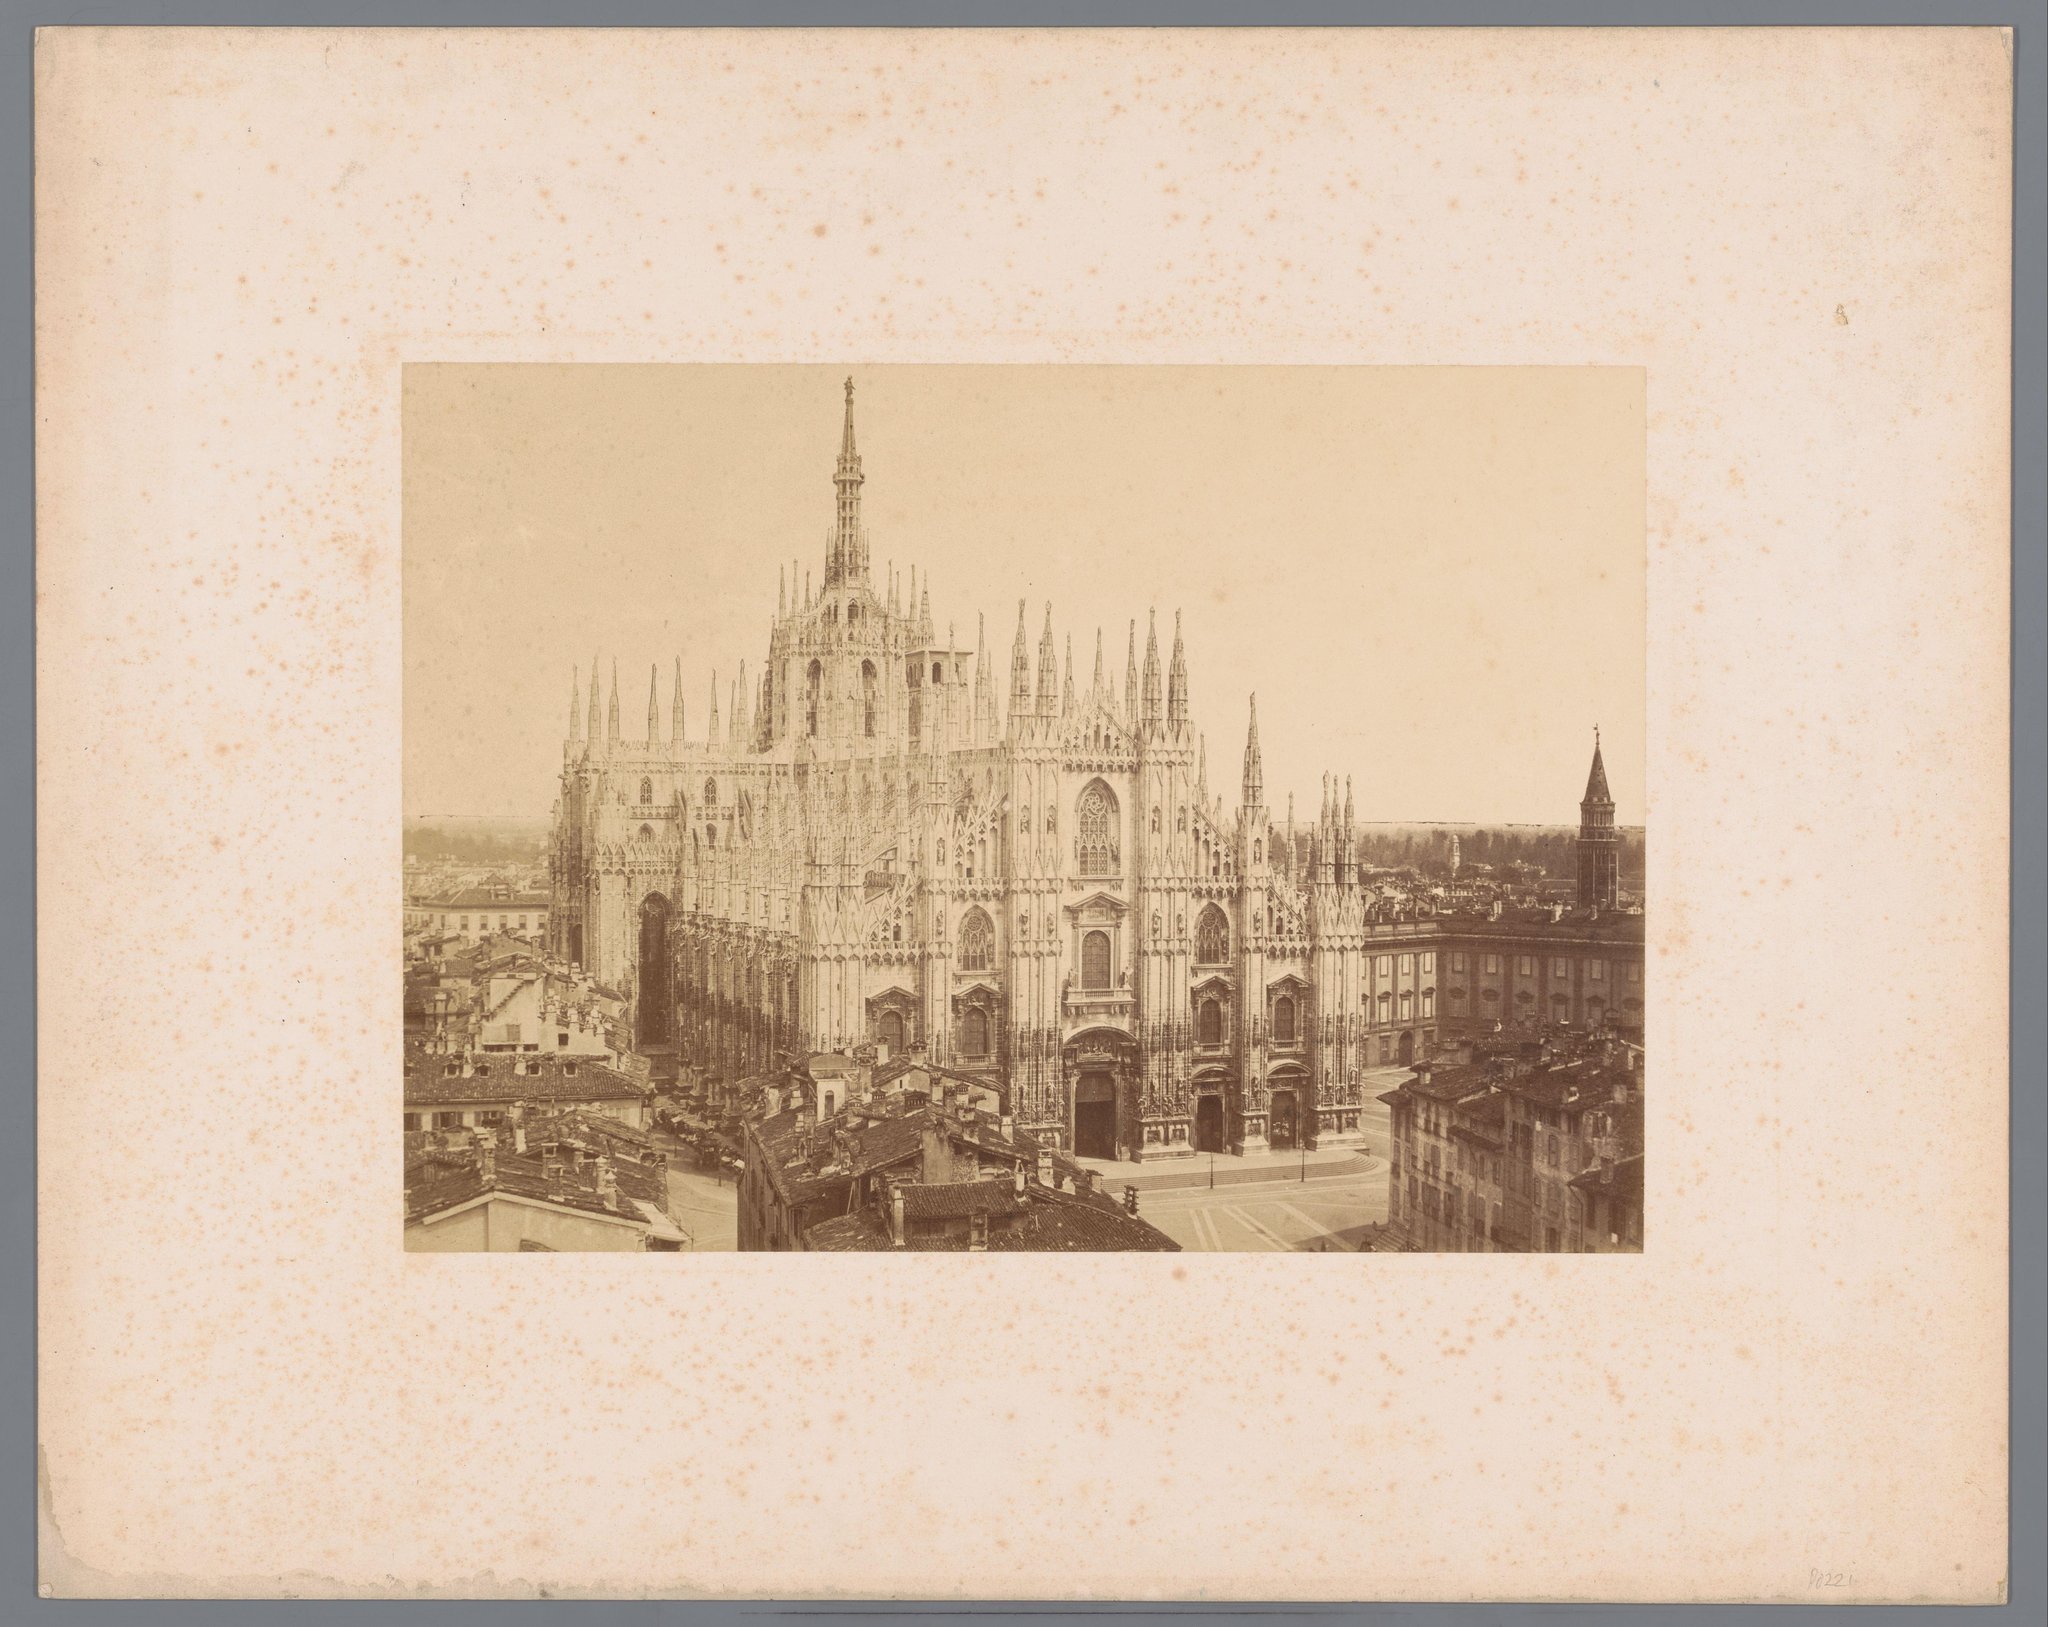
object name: photograph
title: Gezicht op de Dom van Milaan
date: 1860-1865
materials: cardboard, paper, photographic support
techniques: albumen print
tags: dom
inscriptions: signature: ‘Fotografia Artistica P. Pozzi Milano’